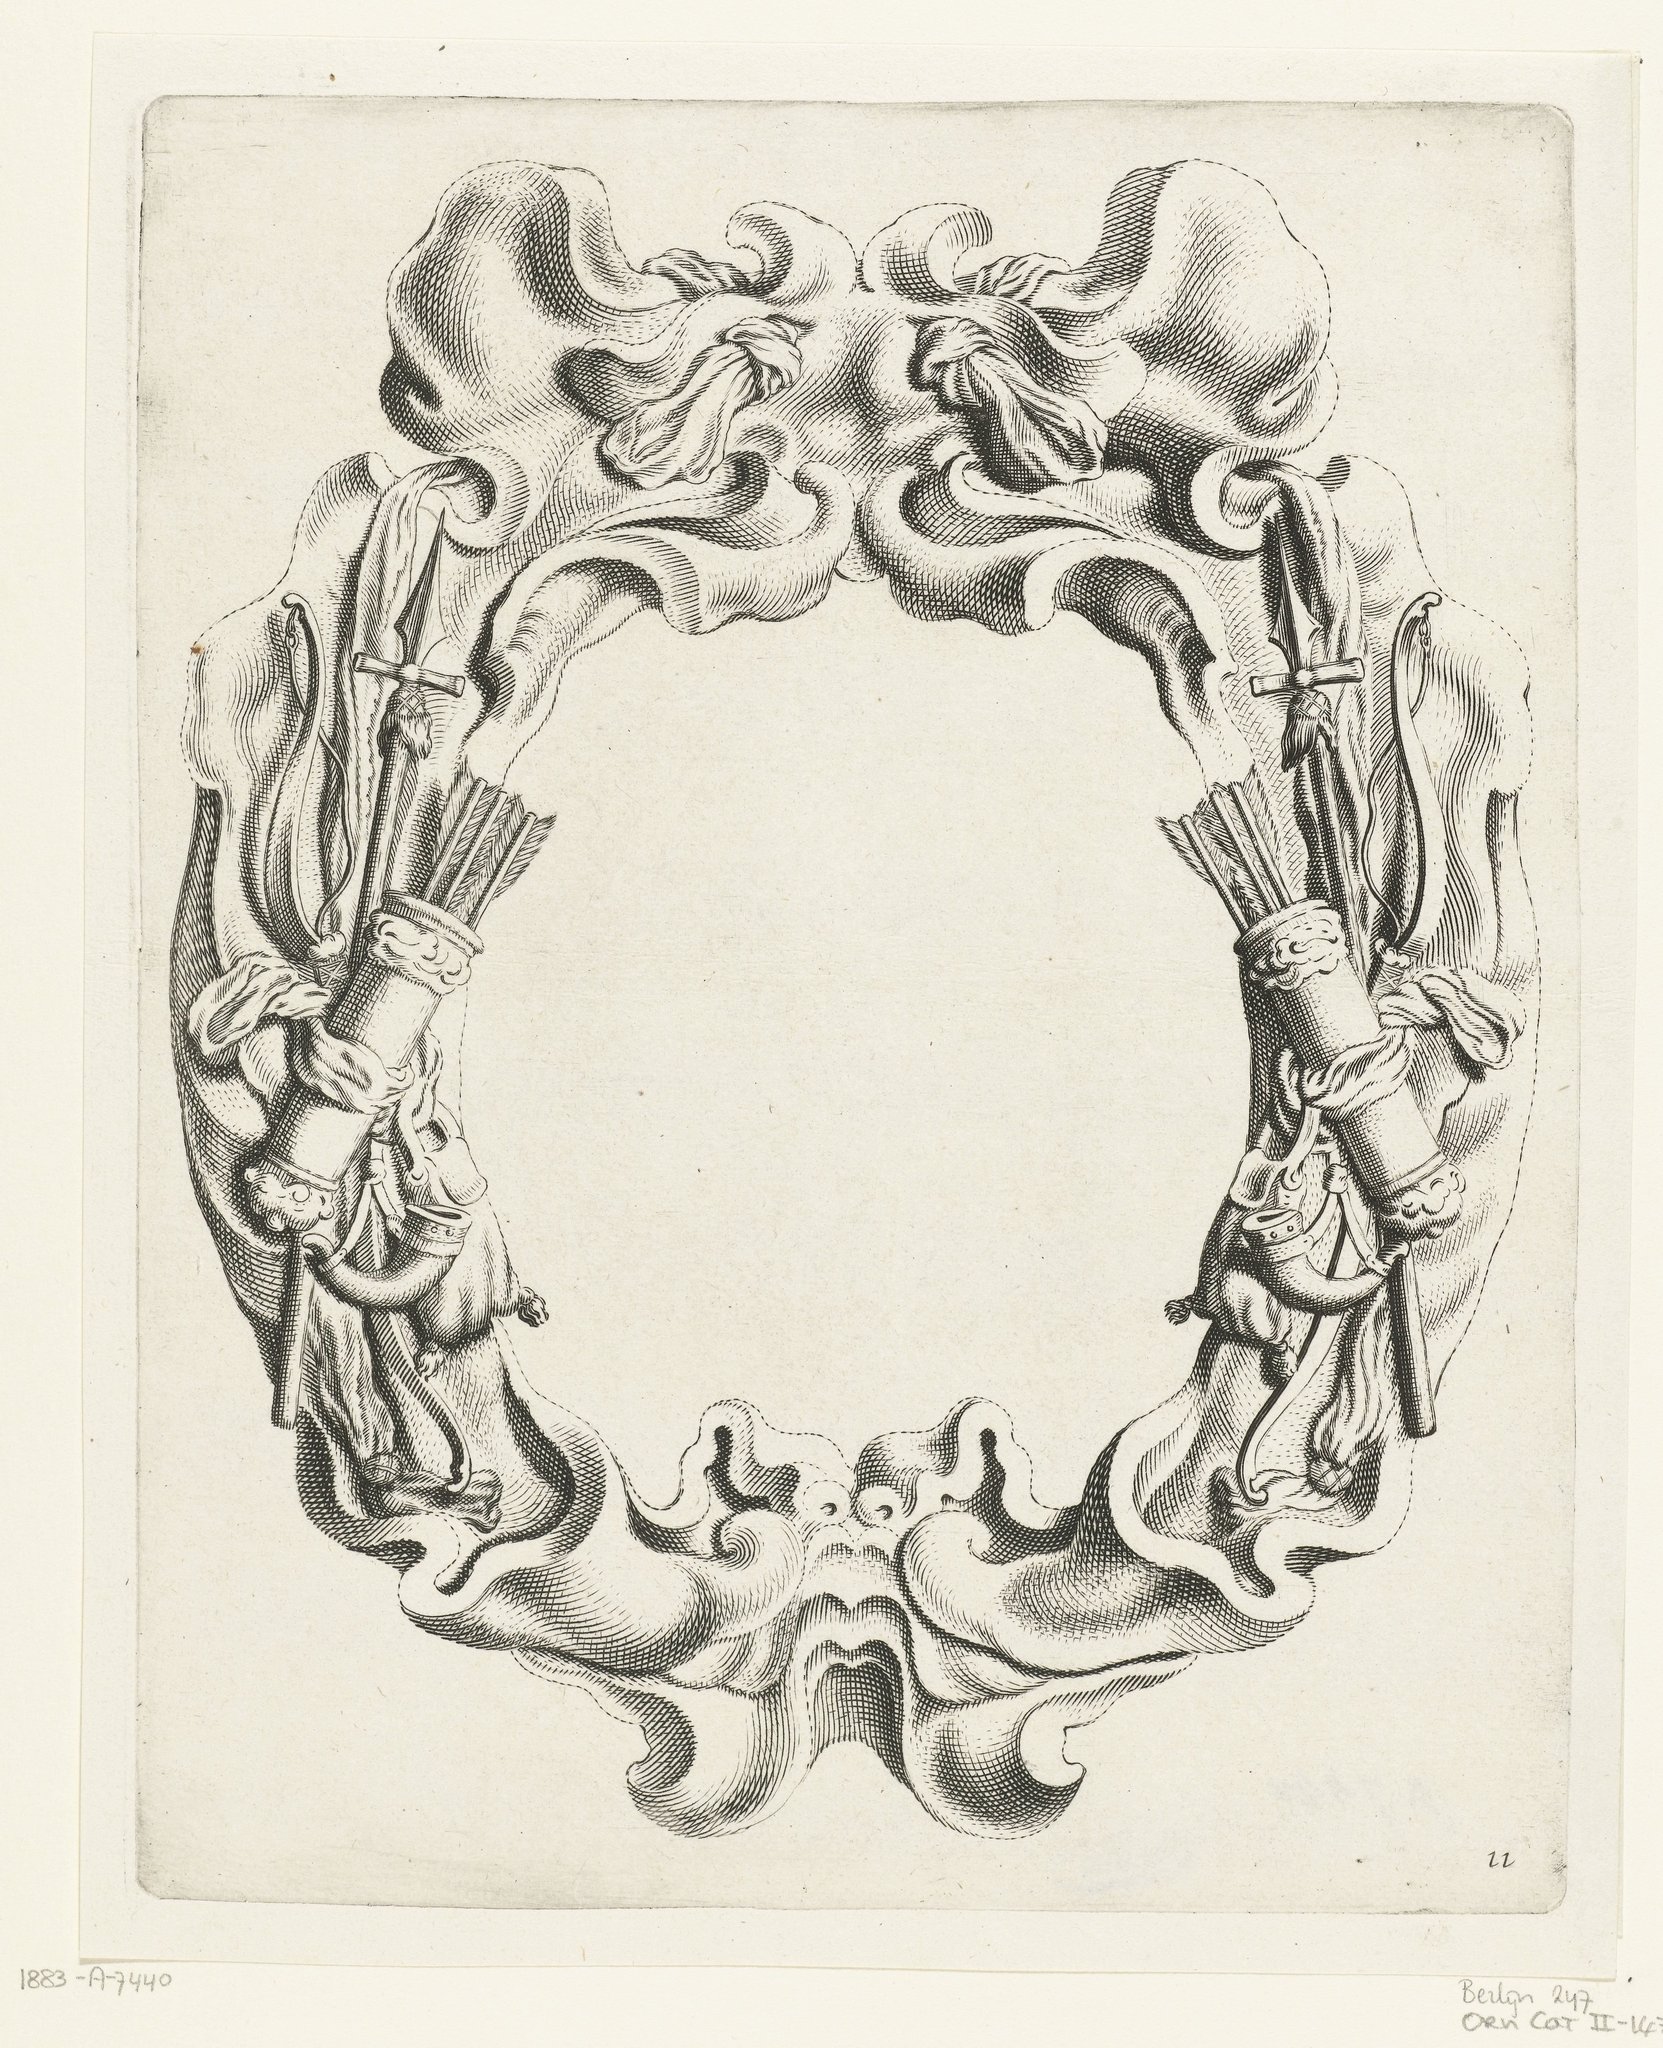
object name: print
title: Cartouche met kwabornament met jachttrofeeën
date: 1640-1655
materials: paper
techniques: engraving, etching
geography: amsterdam